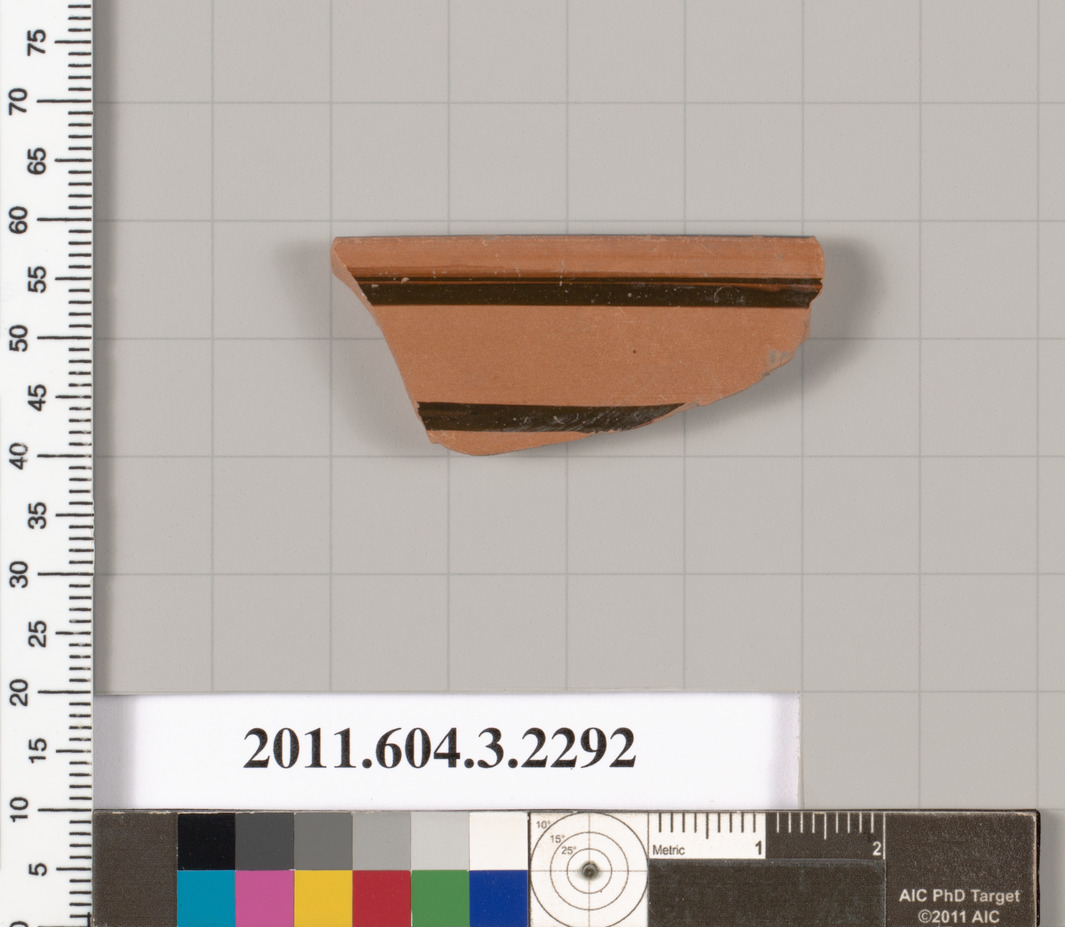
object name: kylix fragment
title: Terracotta rim fragment of a kylix: eye-cup (drinking cup)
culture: greek, attic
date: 540-500 BCE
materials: terracotta